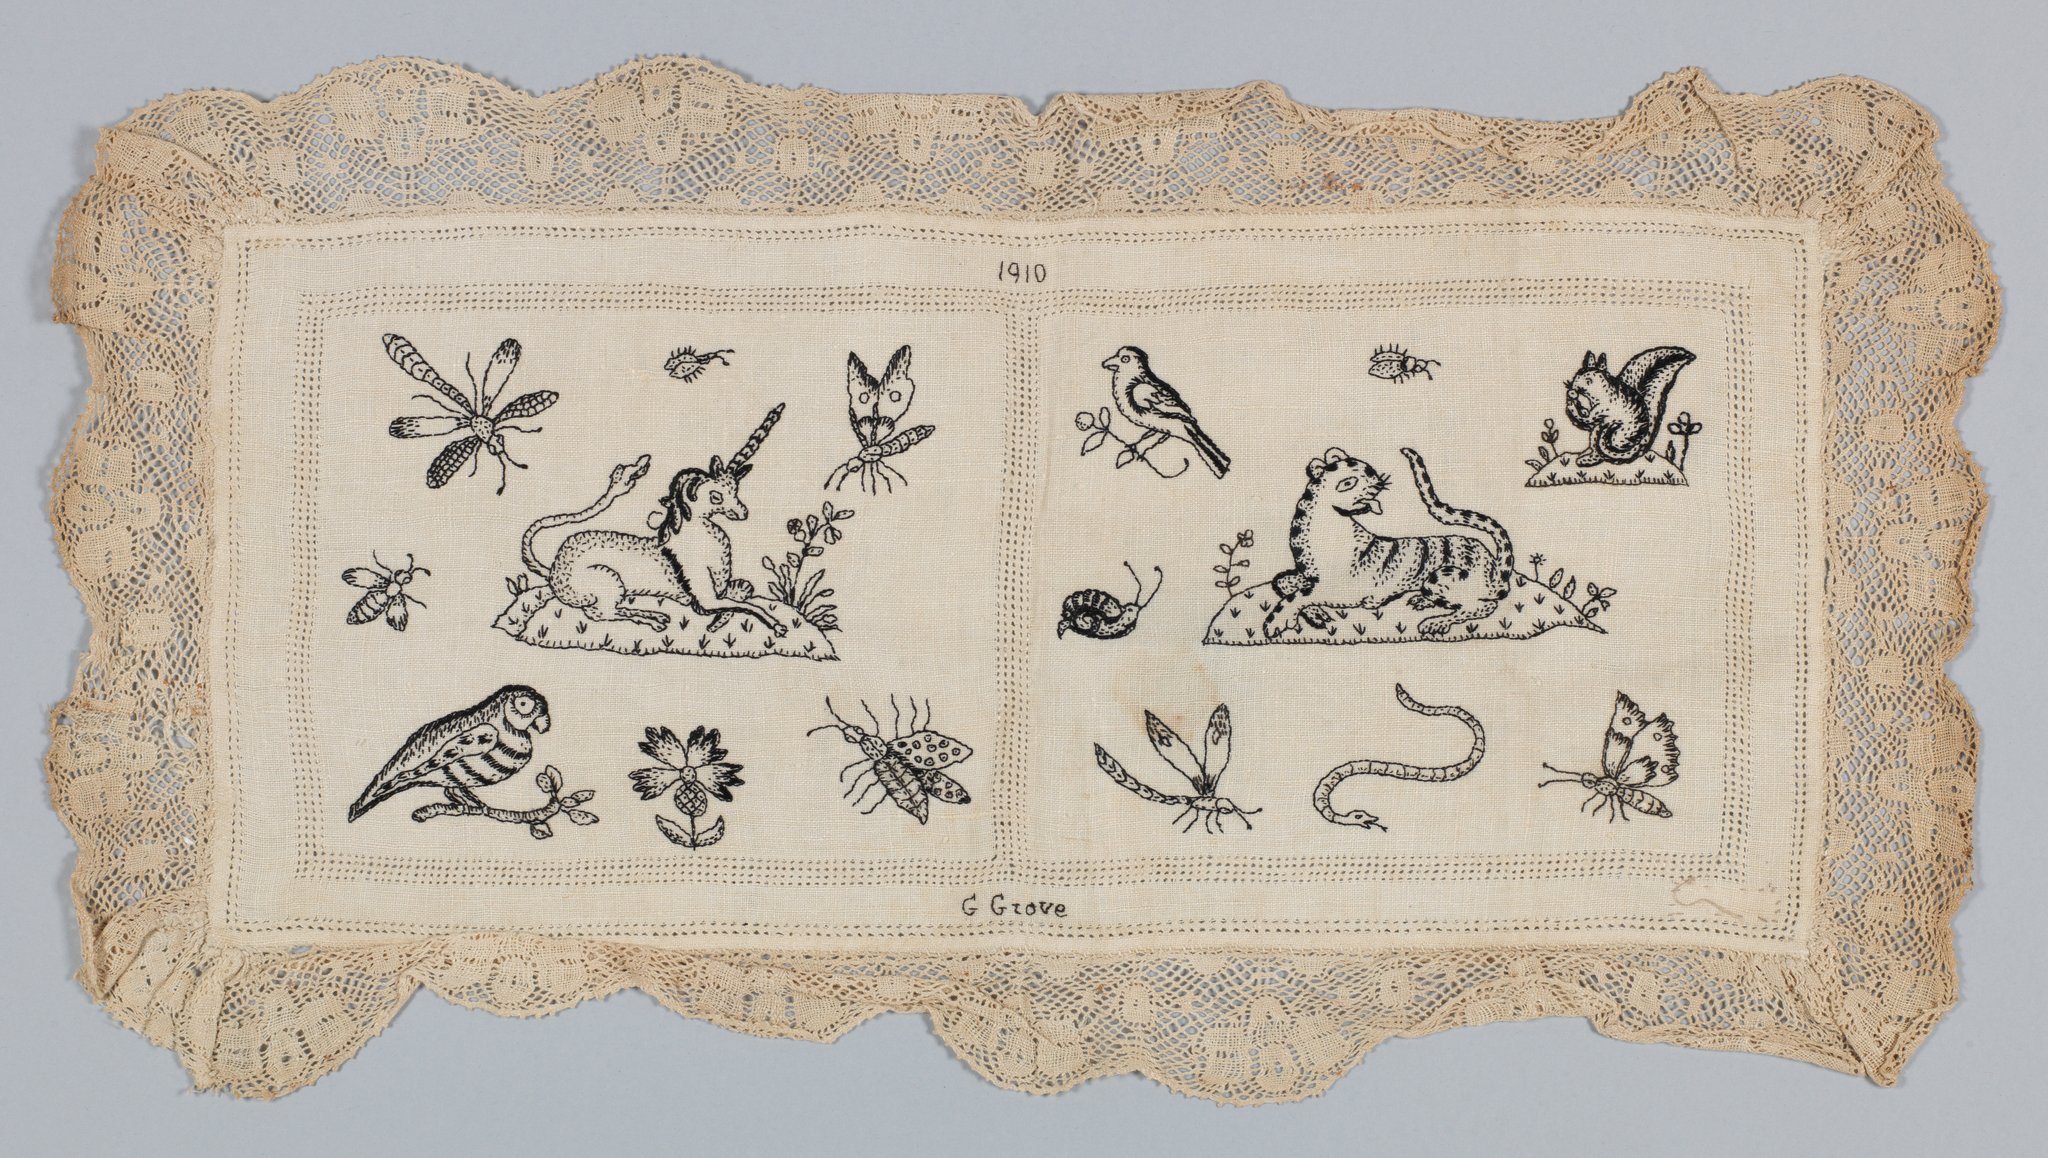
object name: sampler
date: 1910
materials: linen, silk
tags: birds,unicorns,insects,dragonflies,squirrels,tigers